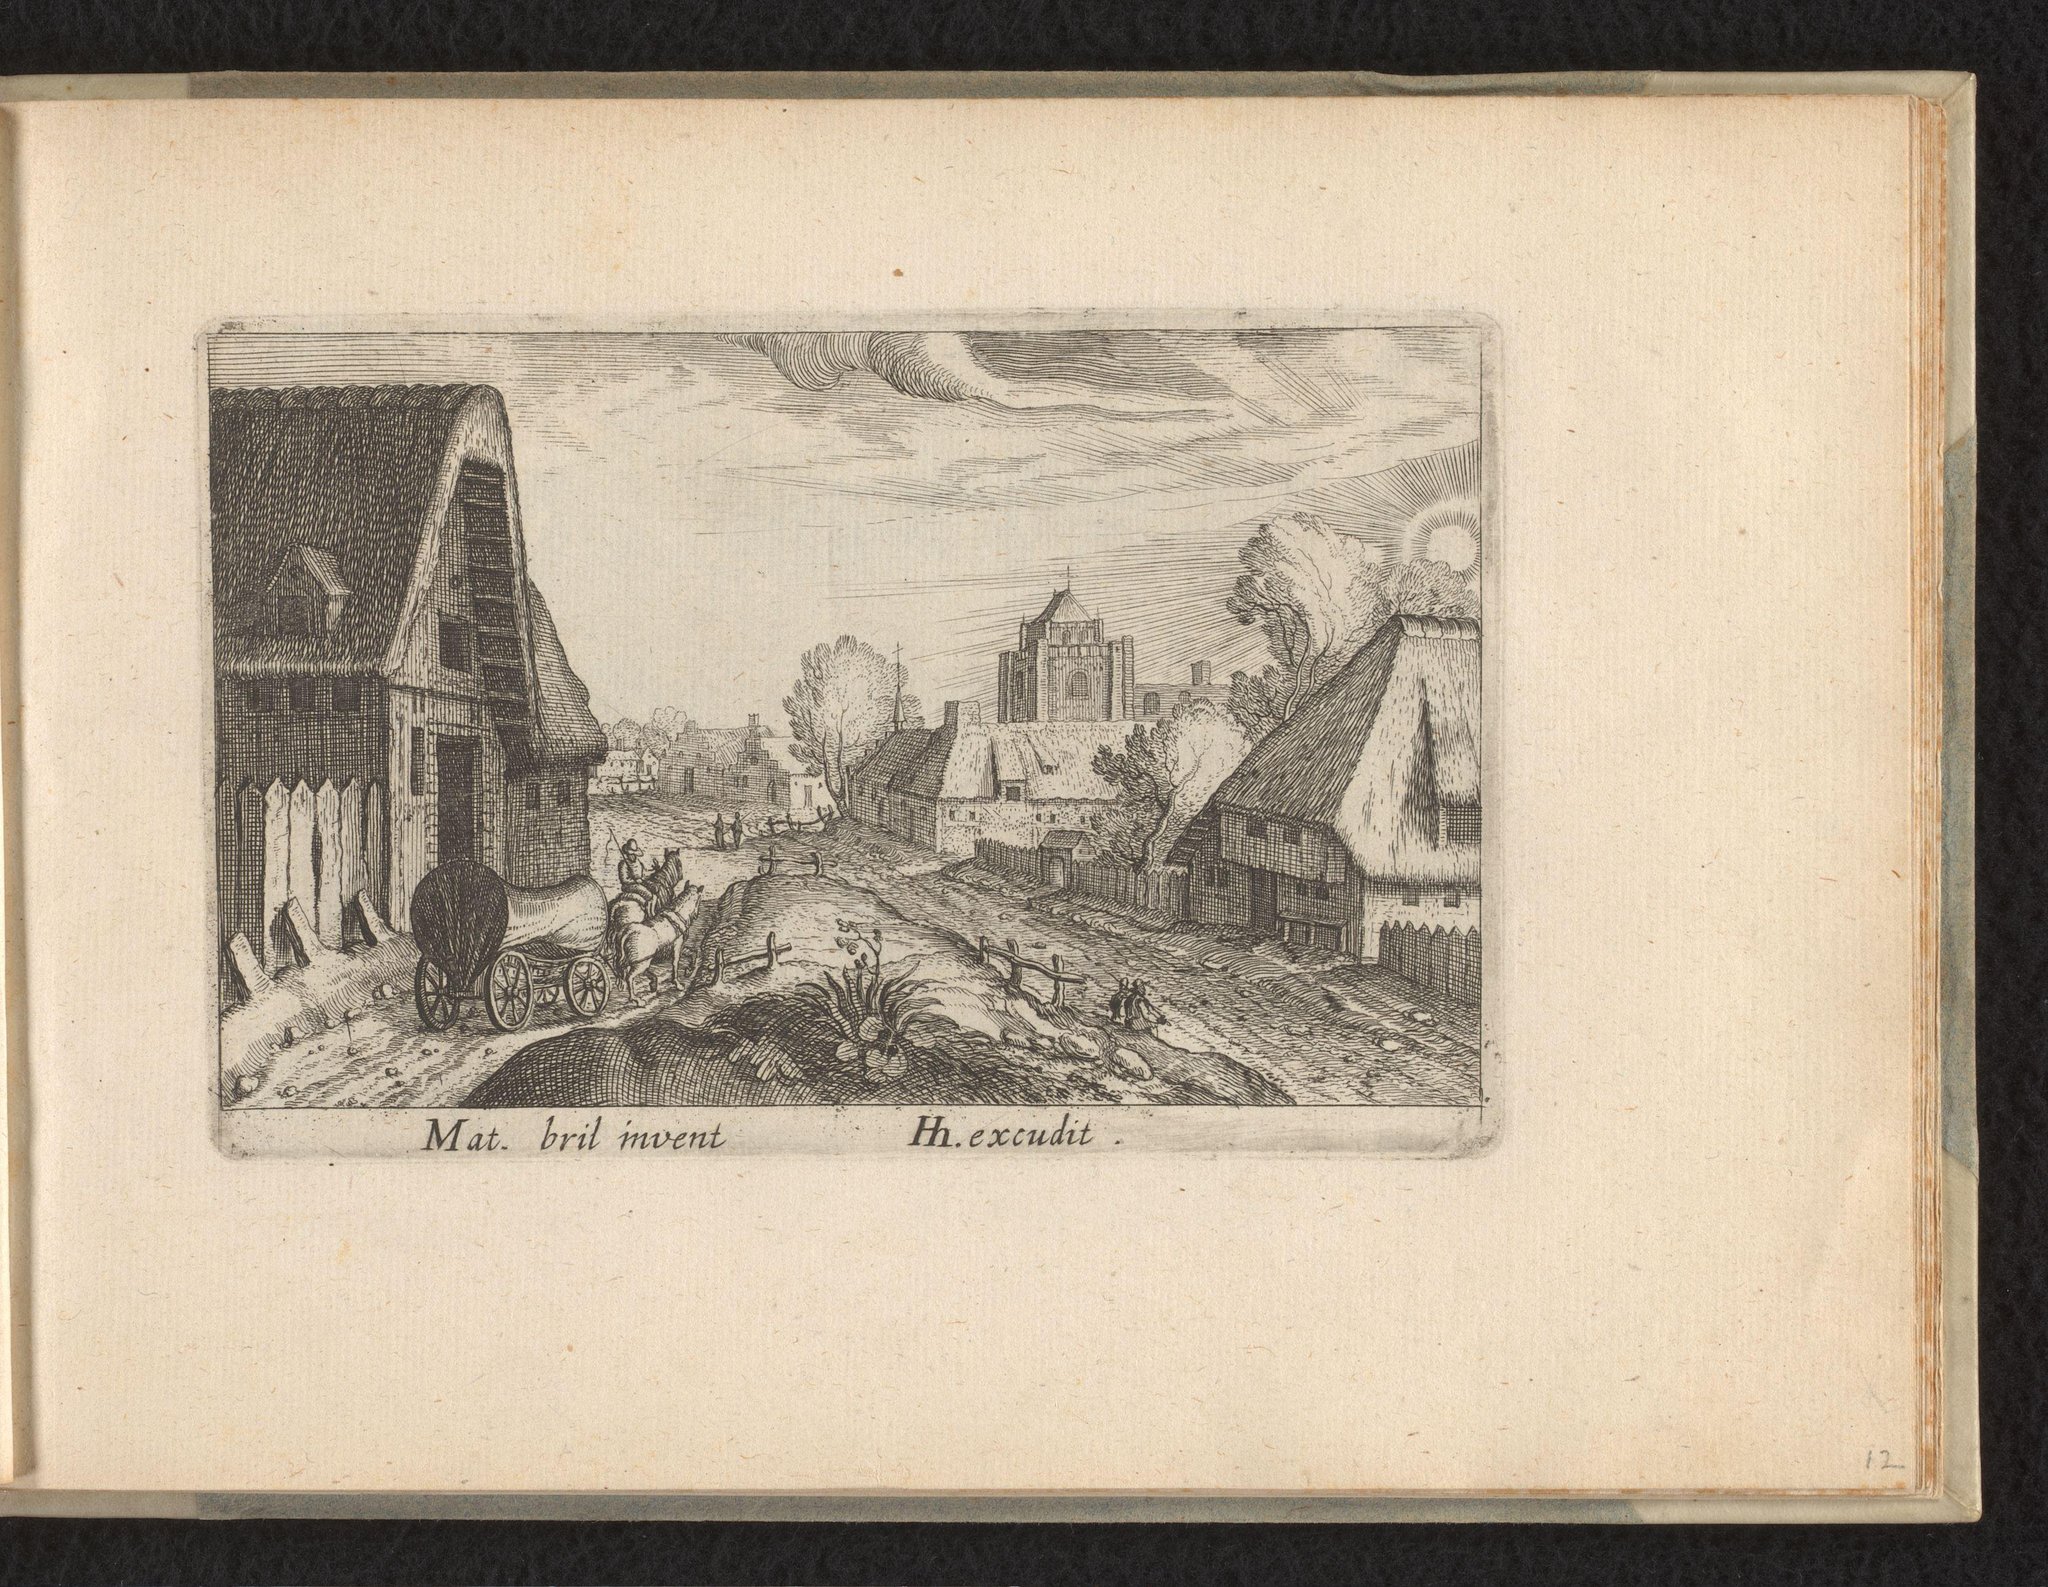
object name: print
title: Topographia Variarum Regionum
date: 1614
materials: paper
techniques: etching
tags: public road in village, (farm) wagon, freight wagon, cart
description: Links een grote boerderij, waarvoor een huifkar getrokken door twee paarden. Rechts boerderijen langs een landweg. Daarachter een kerktoren.